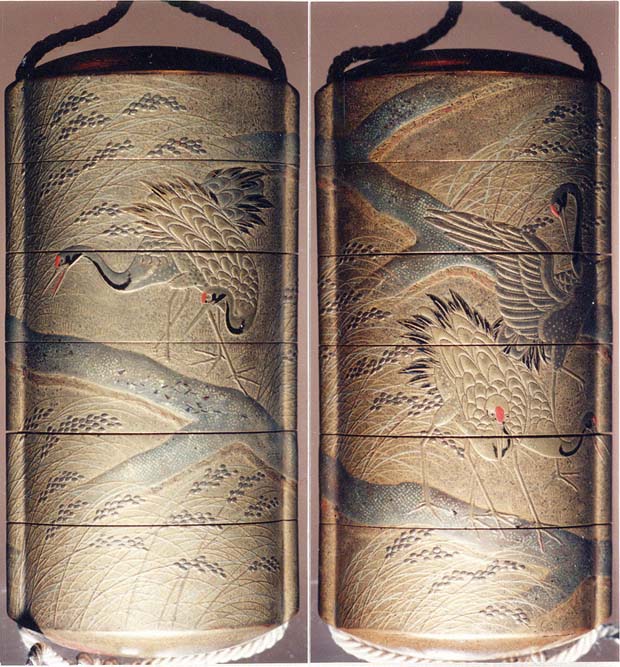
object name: inrō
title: Inrō with Cranes in Rice Fields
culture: japanese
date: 1701-1900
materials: coral, gold, lacquer, shell, silver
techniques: cutting, hiramakie, inlay, kirikane, maki, maki-e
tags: cranes